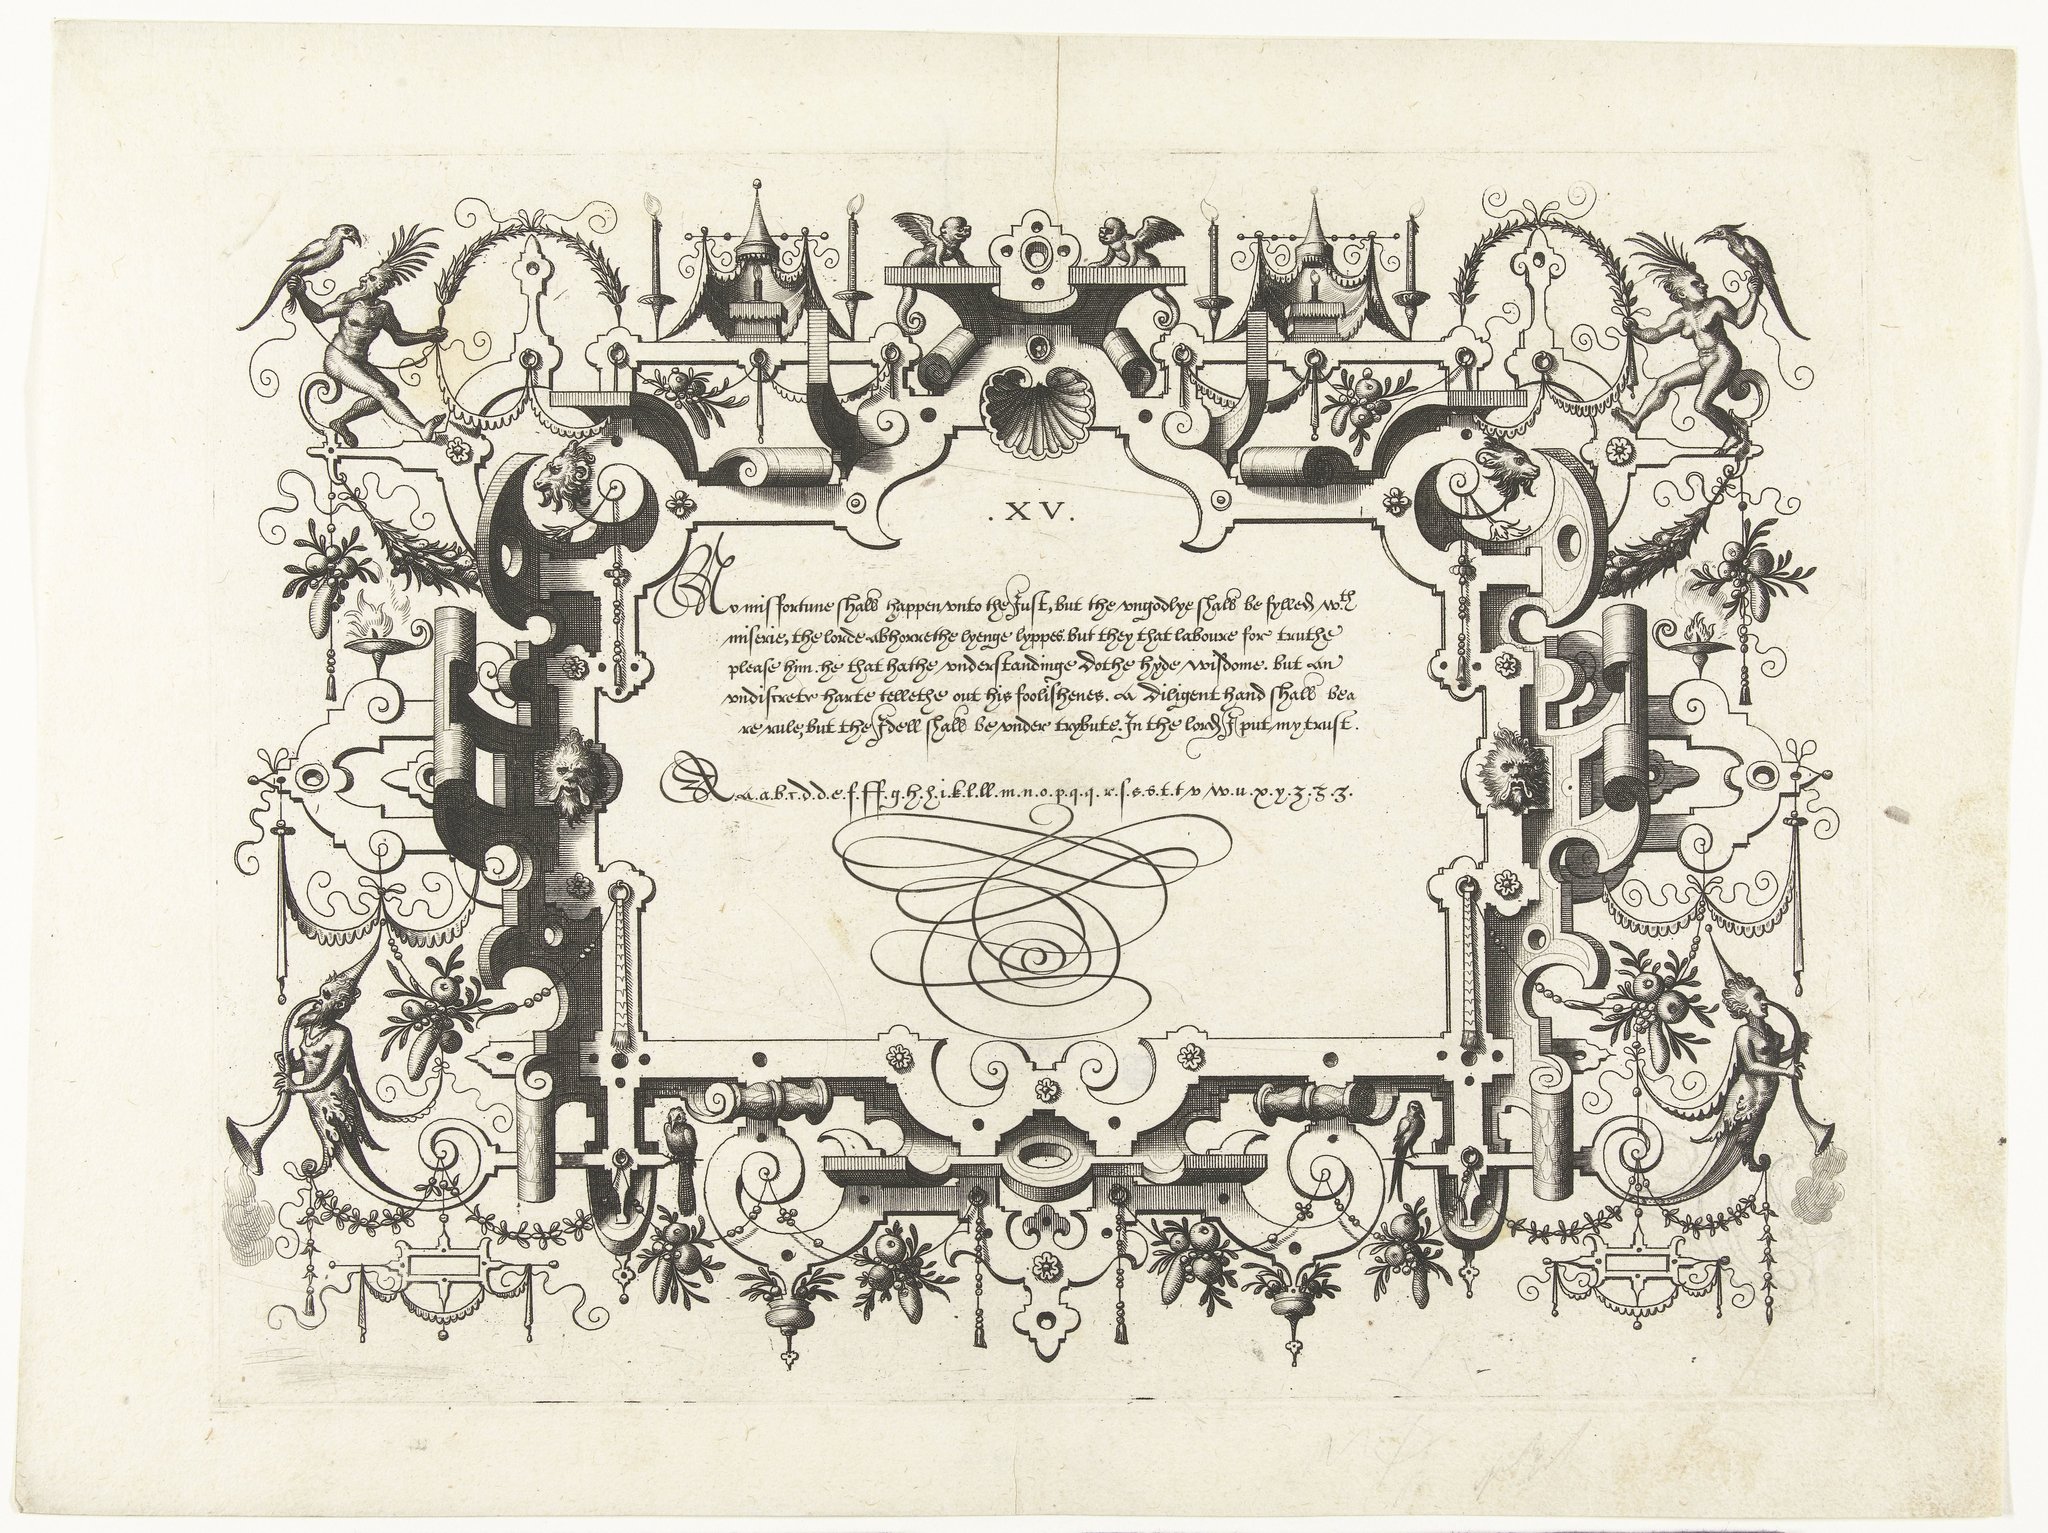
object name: ornament print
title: Cartouche met kalligrafie, rolwerk loopt onderaan uit in hermen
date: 1569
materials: paper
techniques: engraving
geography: netherlands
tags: scrollwork, strapwork ~ ornament, pedestal of a piece of sculpture (perhaps in the form of a herm), ornament ~ cartouche, calligraphy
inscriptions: inscription: ‘JO (?)’, inscription: ‘15a 5-4-'77’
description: Blad XV. Cartouche met tekst No misfortune shall happen.... Het rolwerk loopt linksonder uit in een mannelijke, rechtsonder in een vrouwelijke herme. Beiden blazen wolkjes uit een hoorn die een uitloper van hun neus is. Uit serie van 21 genummerde cartouches met kalligrafie in een omlijsting van rol- en beslagwerk met grotesken, guirlandes en mascarons.